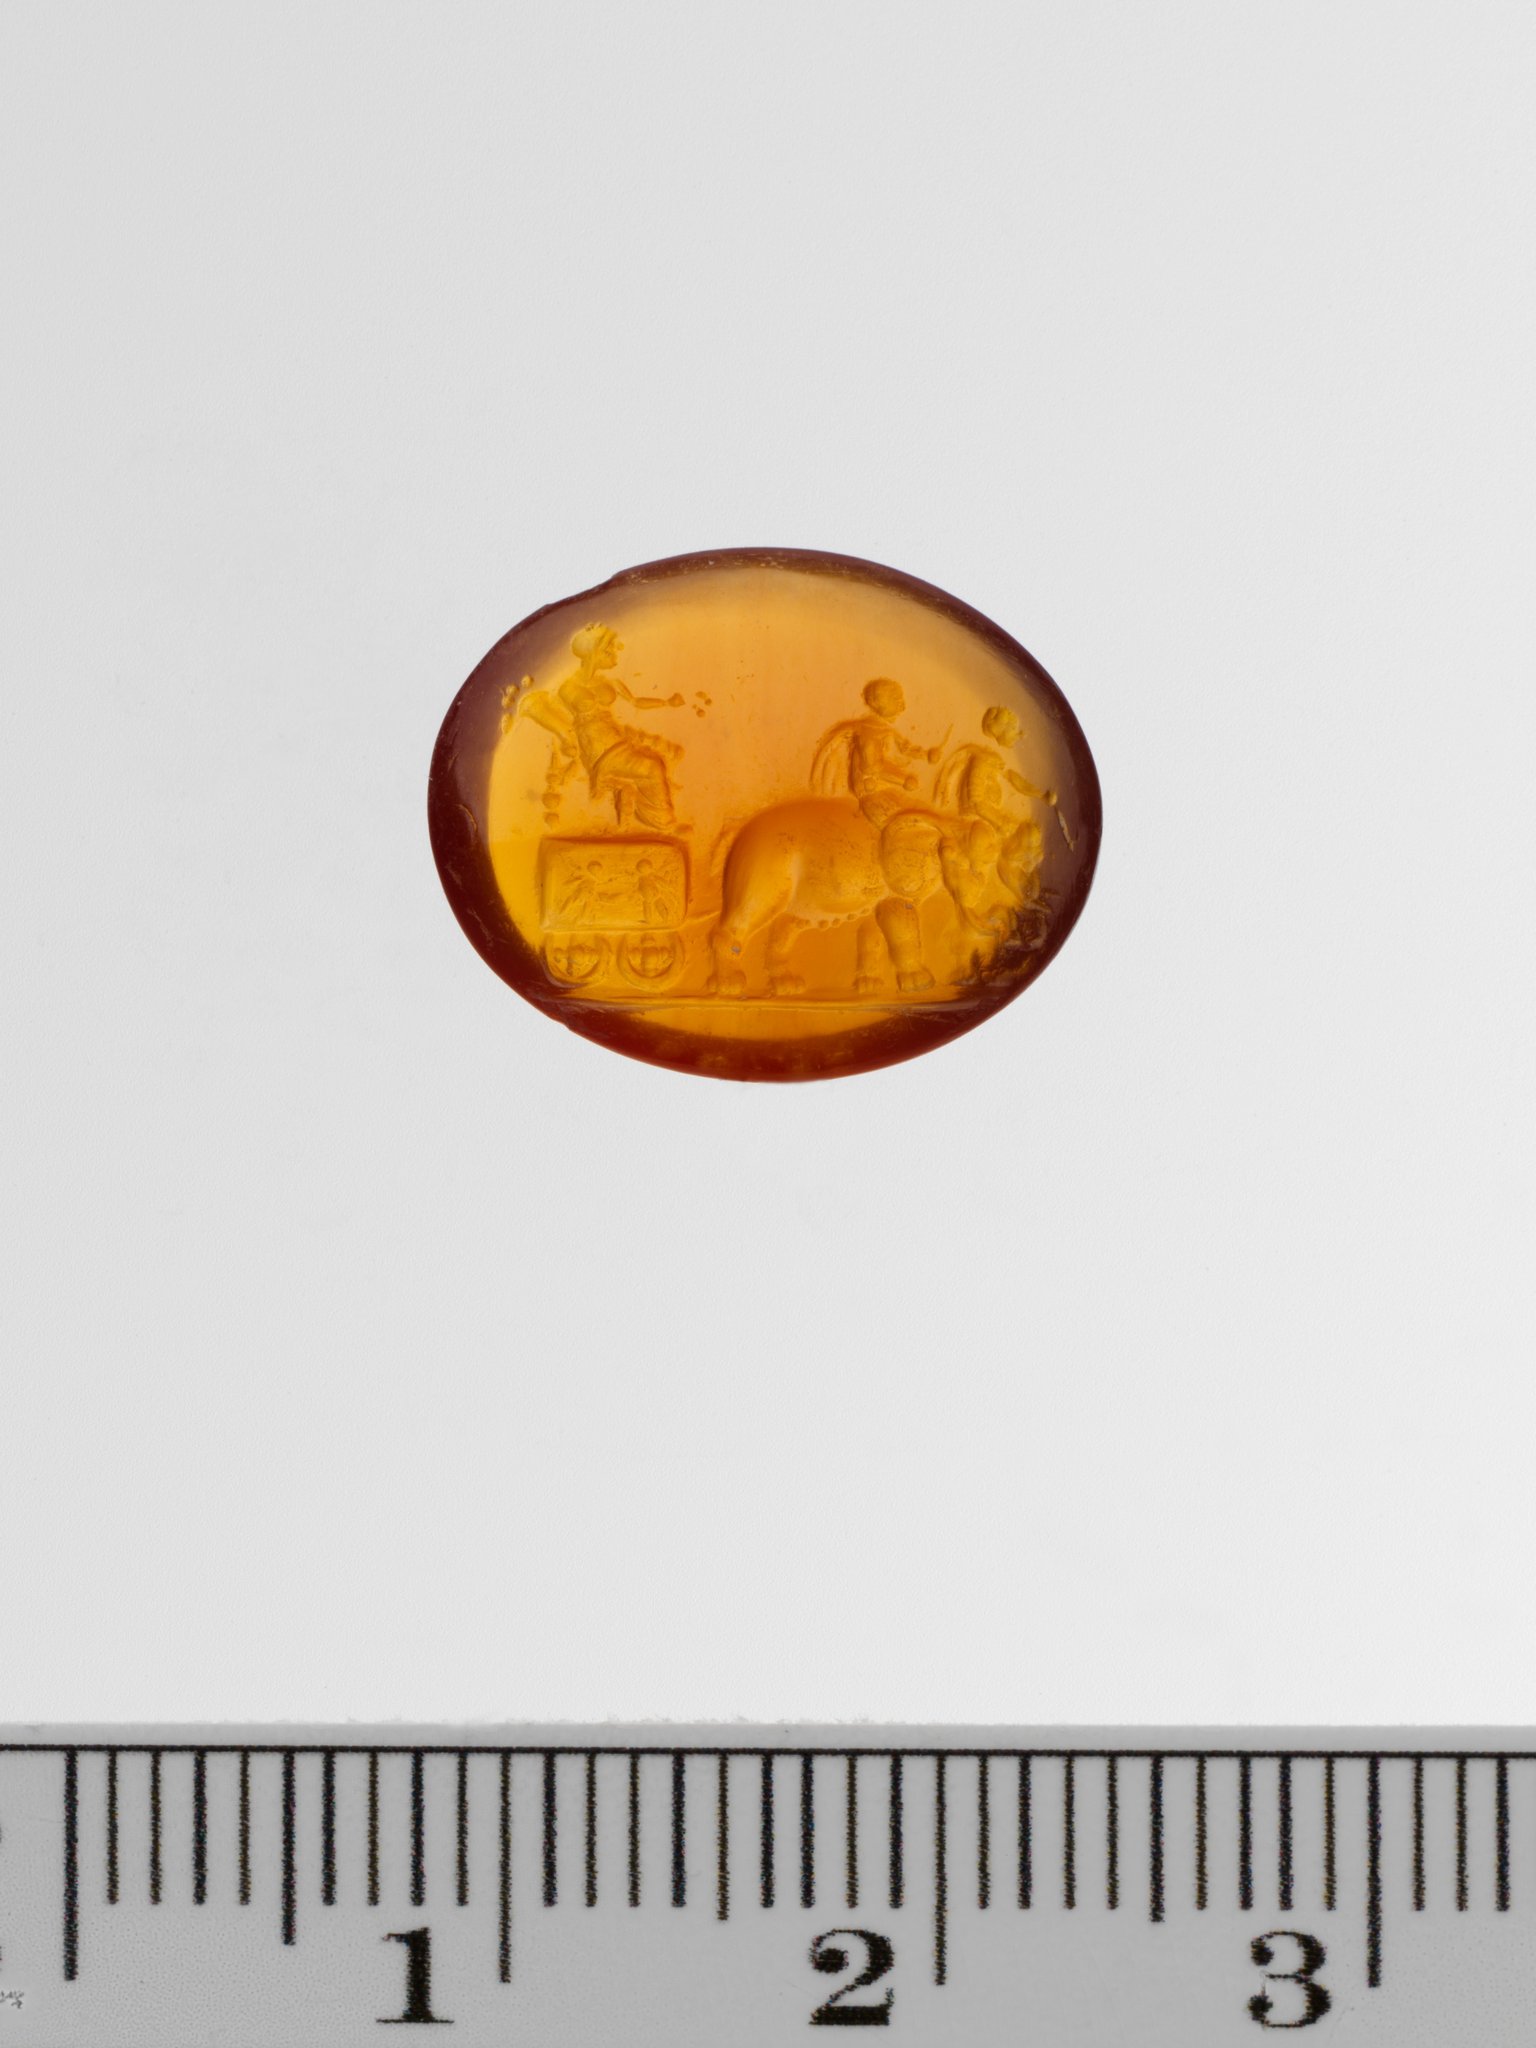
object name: intaglio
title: Sard ring stone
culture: roman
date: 1-100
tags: elephants,goddess,chariots